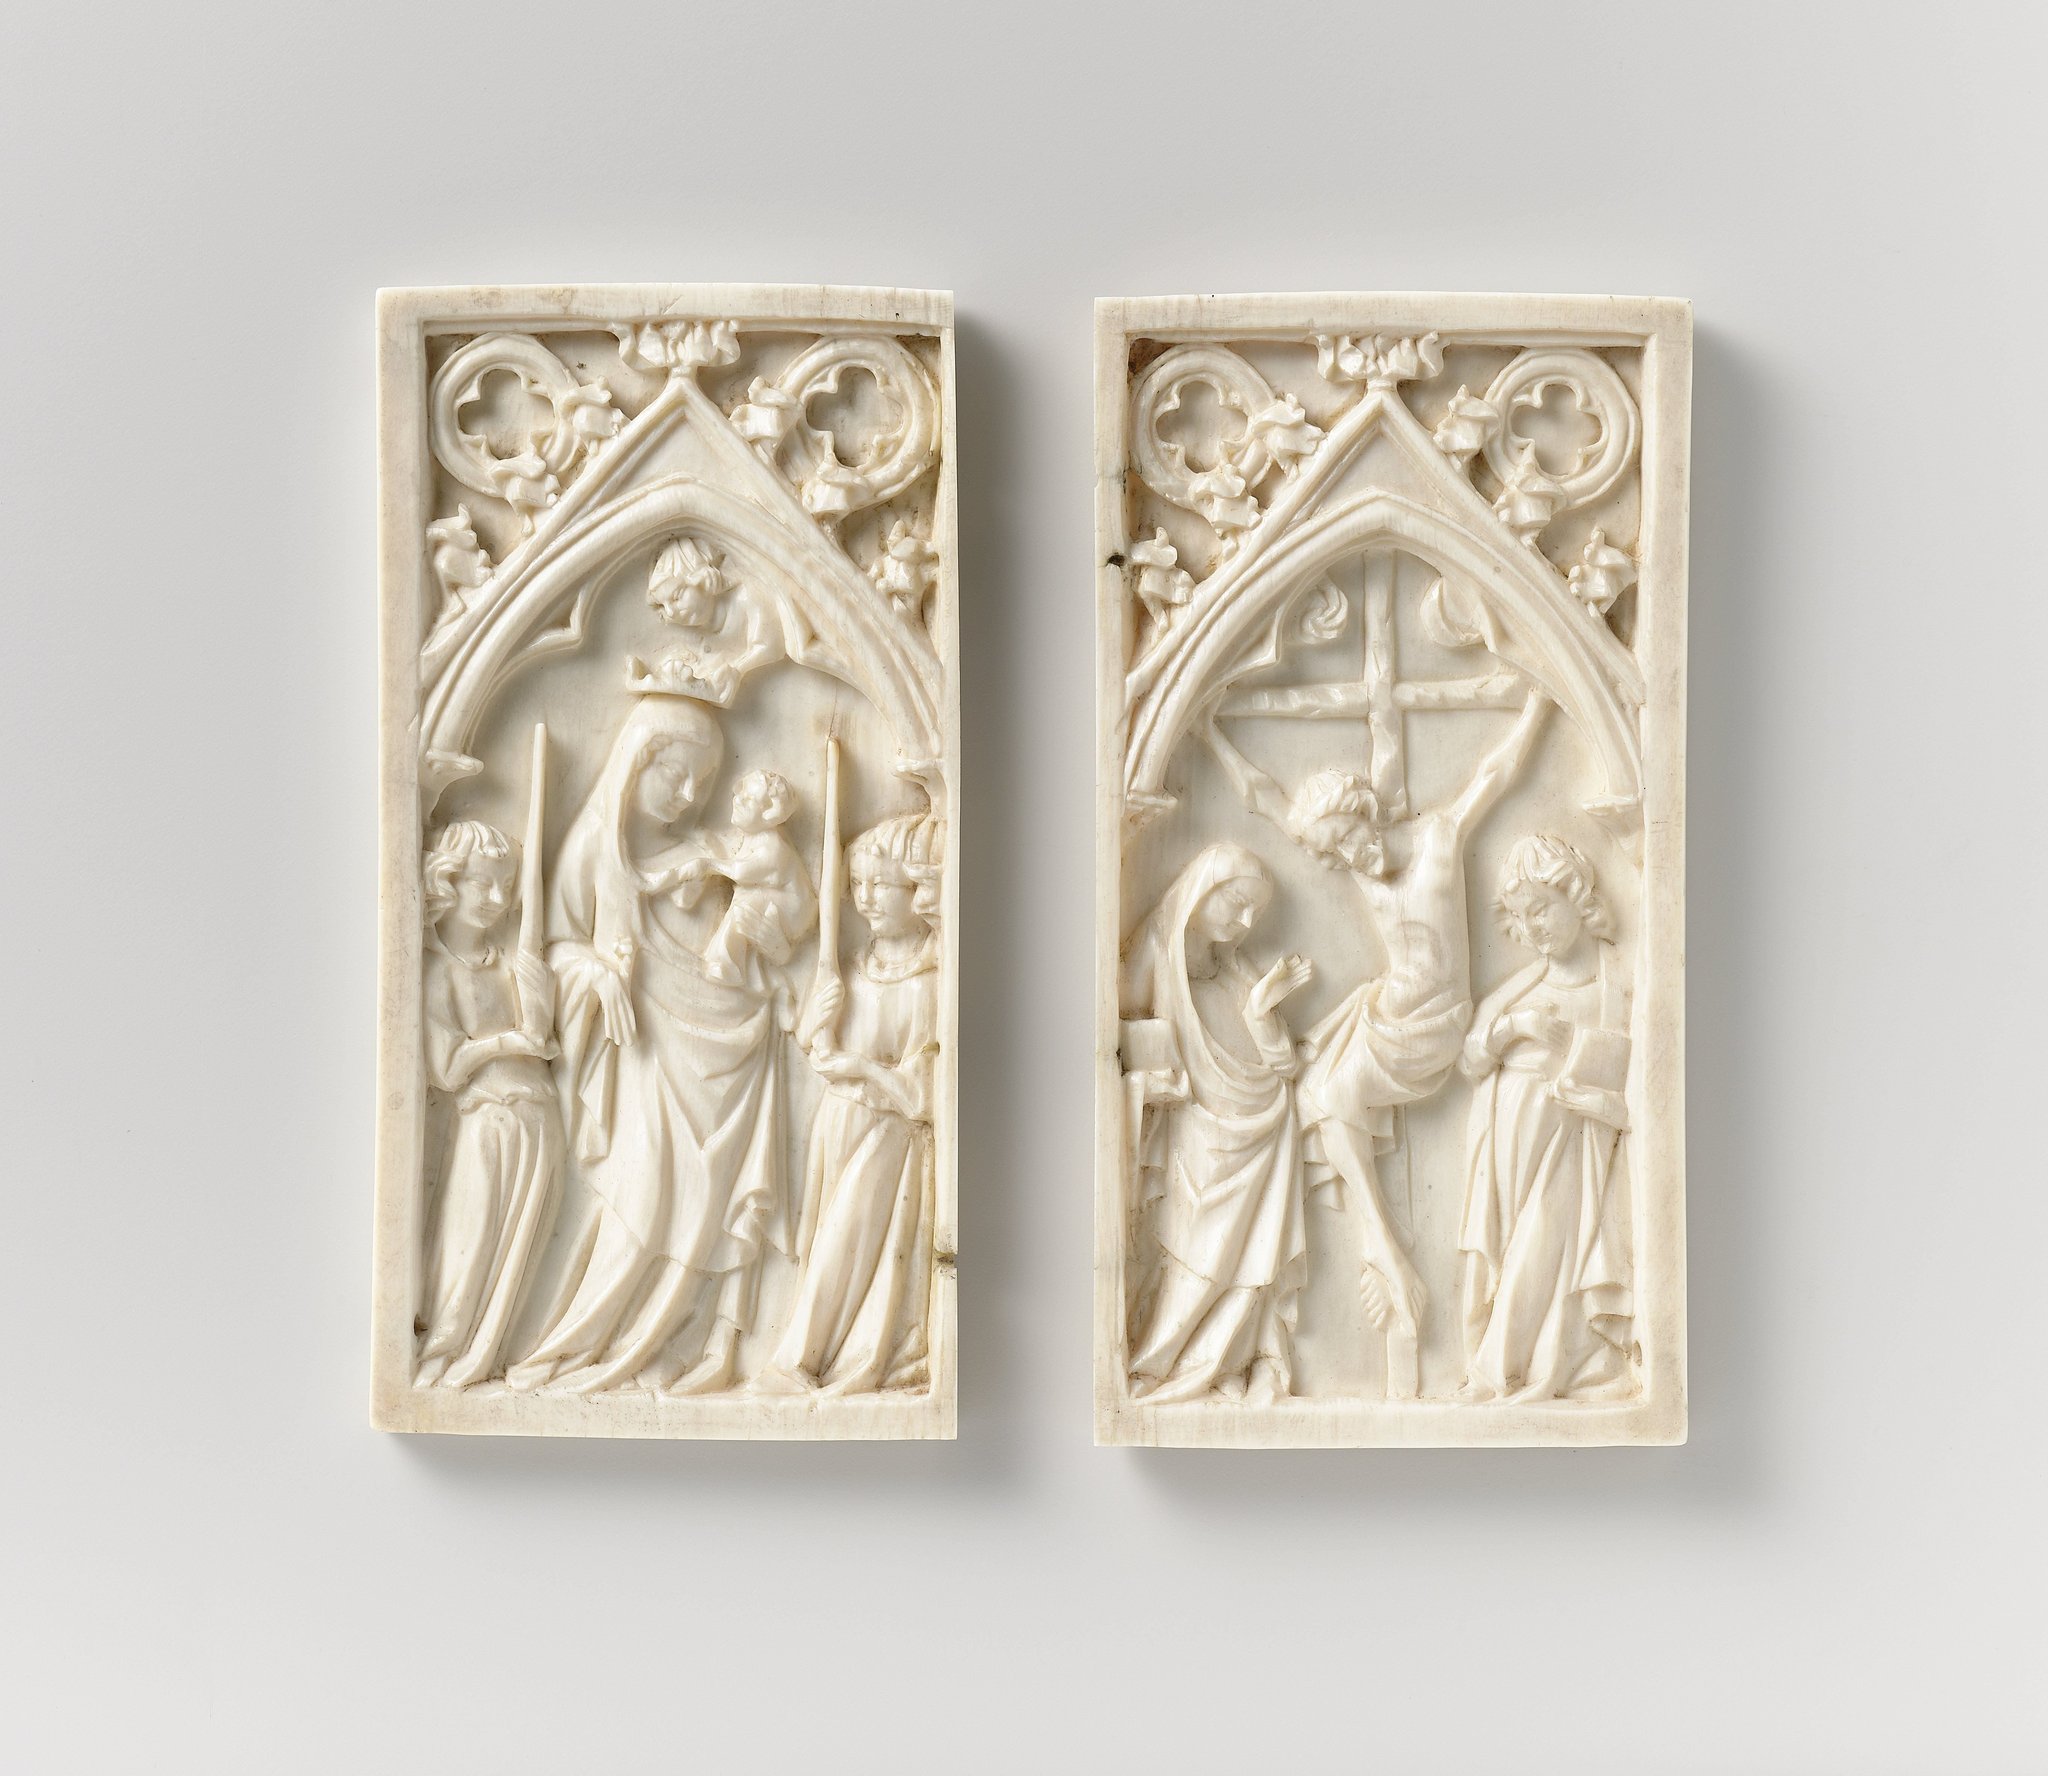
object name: diptych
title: Diptych with the Virgin and Child and the Crucifixion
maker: Anonymous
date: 1350-1400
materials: copper, ivory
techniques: cutting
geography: ile-de-france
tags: mary standing (or half-length), the christ-child sitting on her arm (christ-child to mary's left), angel(s) with torch, coronation of mary by one or more angels, crucified christ with mary and john on either side of the cross; holy rood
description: Op de linker vleugel staat, onder een drielobbige gotische spitsboog met in de zwikken vierpassen, Maria tussen twee haar toegewende, toortsdragende engelen. Zij heeft in de rechterhand een lelie en houdt op de linkerarm het kind, dat met een hand haar sluier vasthoudt en zijn rechterarm om haar hals heeft geslagen. Een engel houdt een kroon boven het hoofd van Maria. Op de rechter vleugel staan Maria en Johannes onder het kruis, waarboven zon en maan. Beide figuren houden een boek in de hand, Maria maakt met de linkerhand een gebaar naar Christus, Johannes houdt de rechterhand voor de borst.